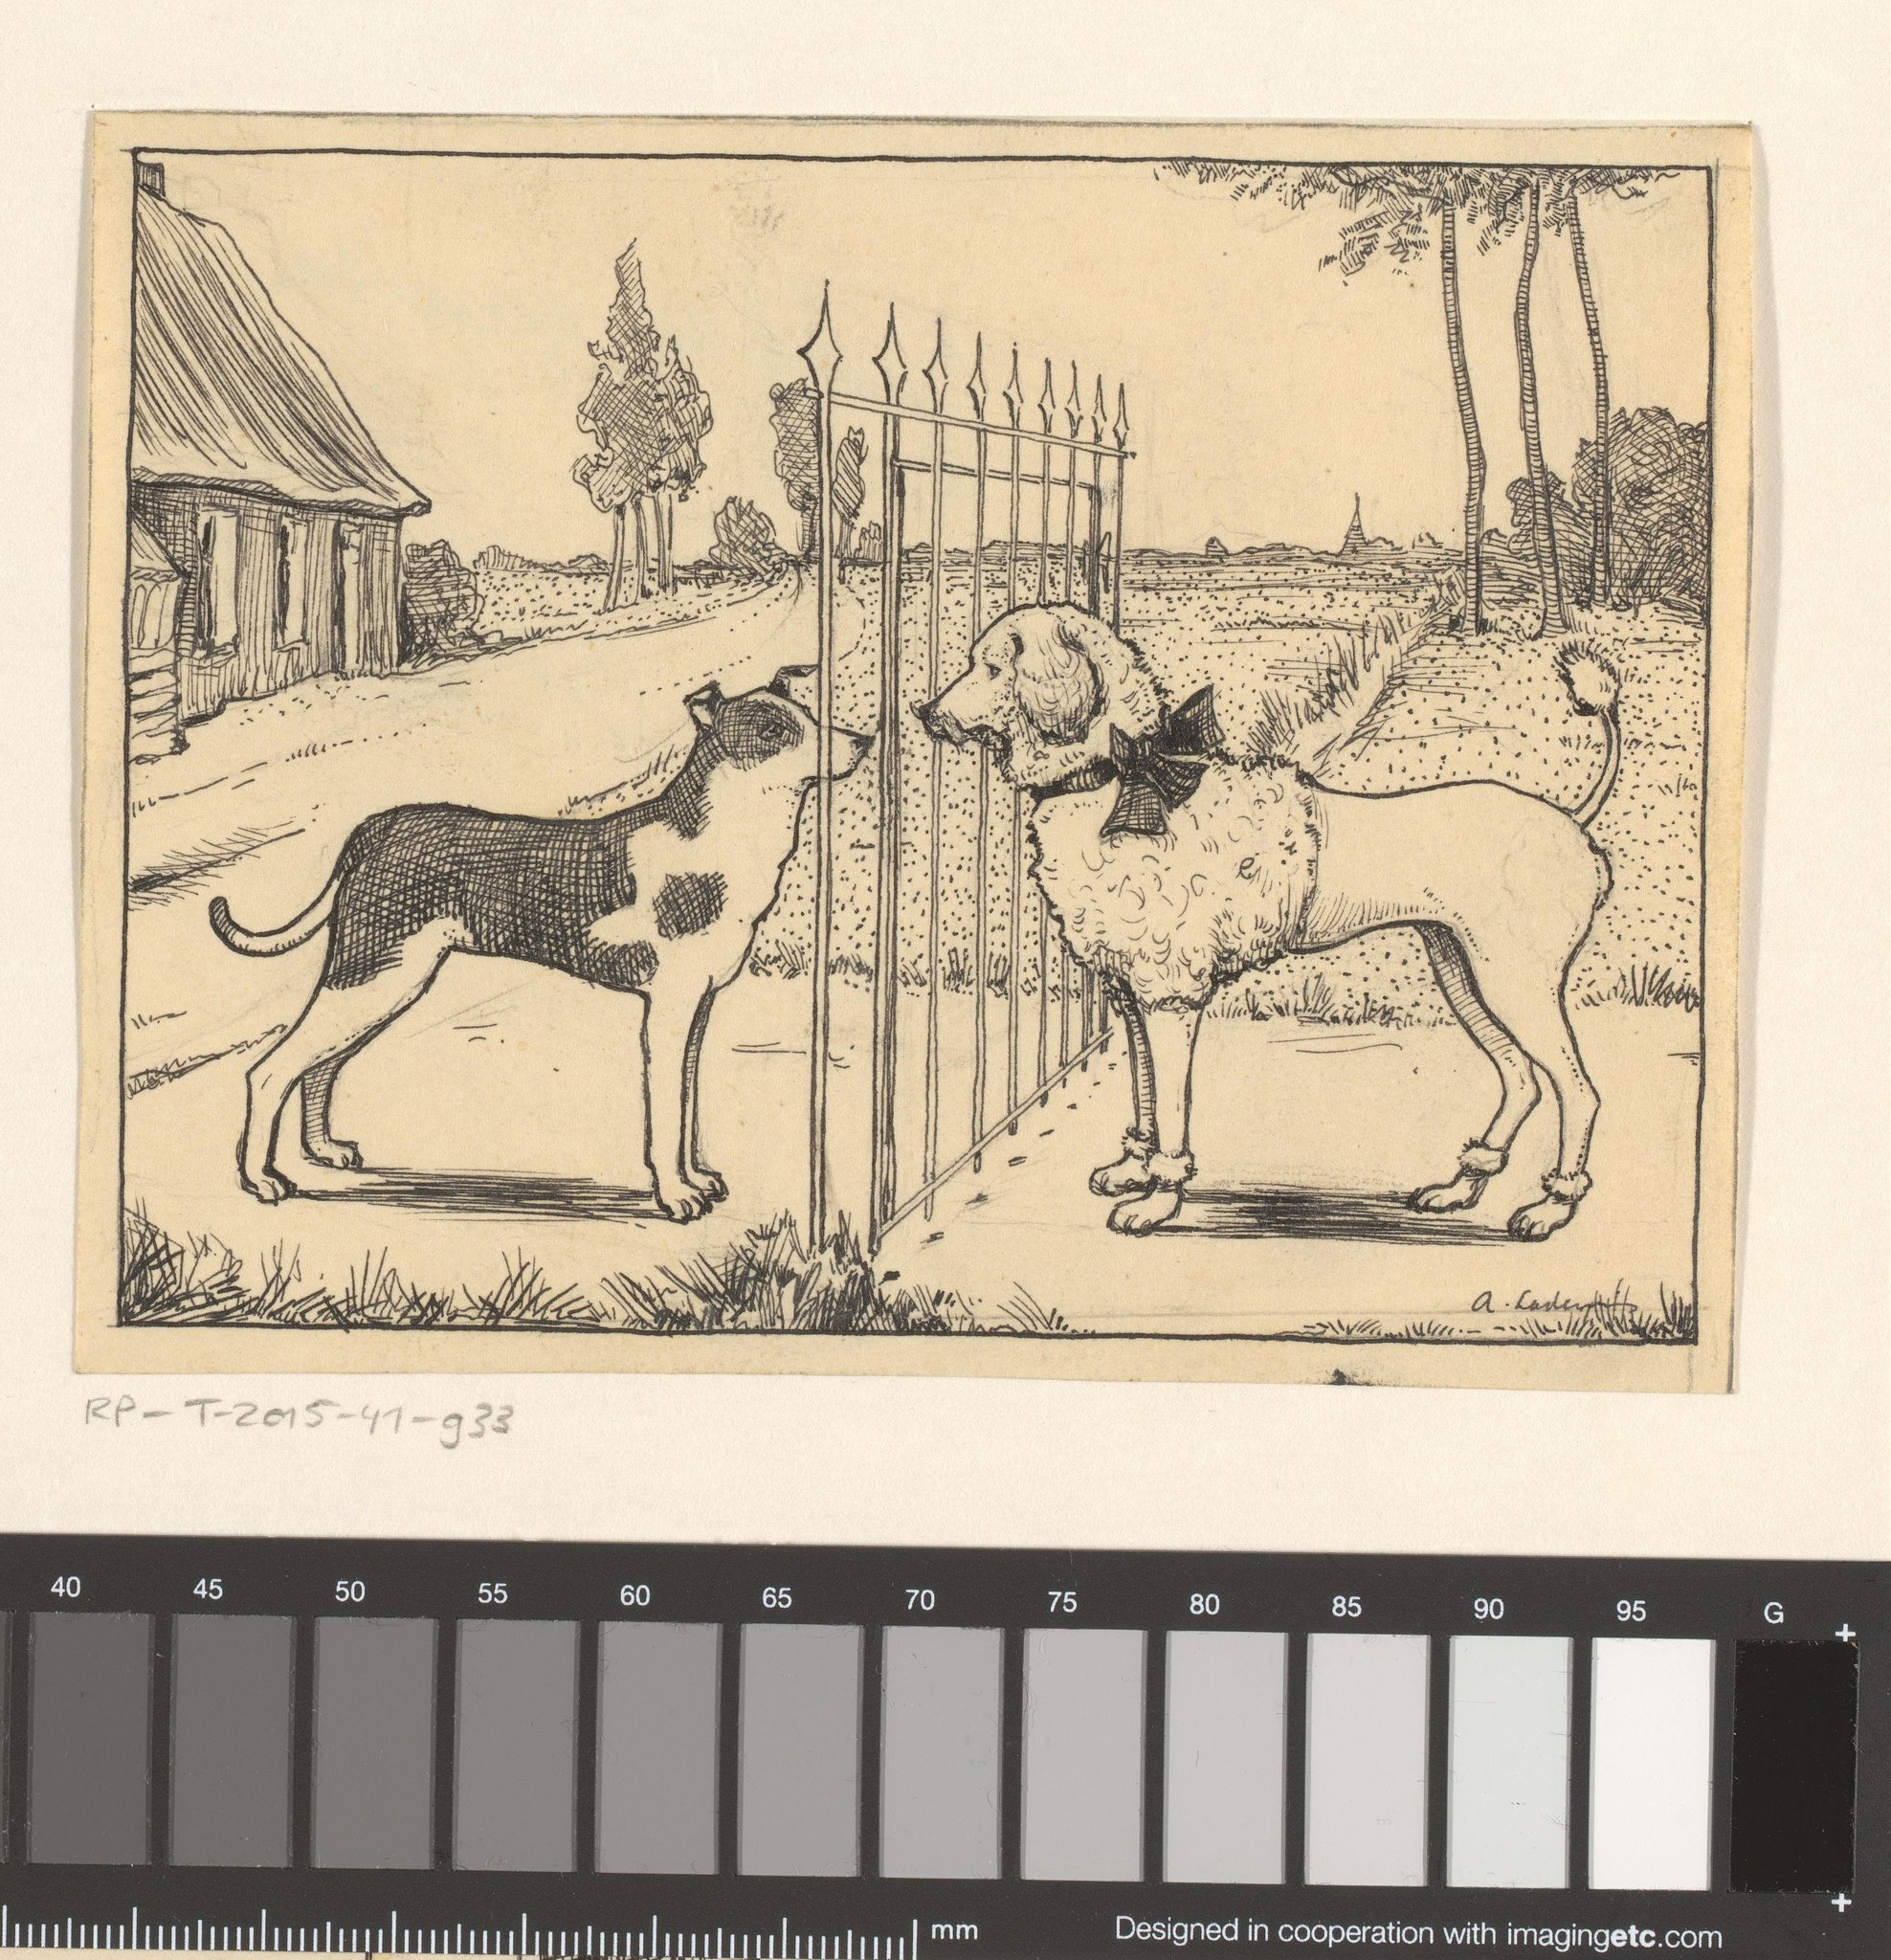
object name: drawing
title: Honden Tilo en Poedel bij een hek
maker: adri ladenius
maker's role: draughtsman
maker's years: 1883-1953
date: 1916-1917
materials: ink, paper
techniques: pen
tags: fence, wall, paling, dog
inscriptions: collector's mark: Lugt 2228, annotation: ‘Tilo's Poedel’, signature: ‘A. Ladenius’, :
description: Twee honden staan tegenover elkaar aan weerszijden van een hek. De hond links, Tilo, staat op het erf van een boerderij. De hond rechts, Poedel, draagt een strik om de nek.